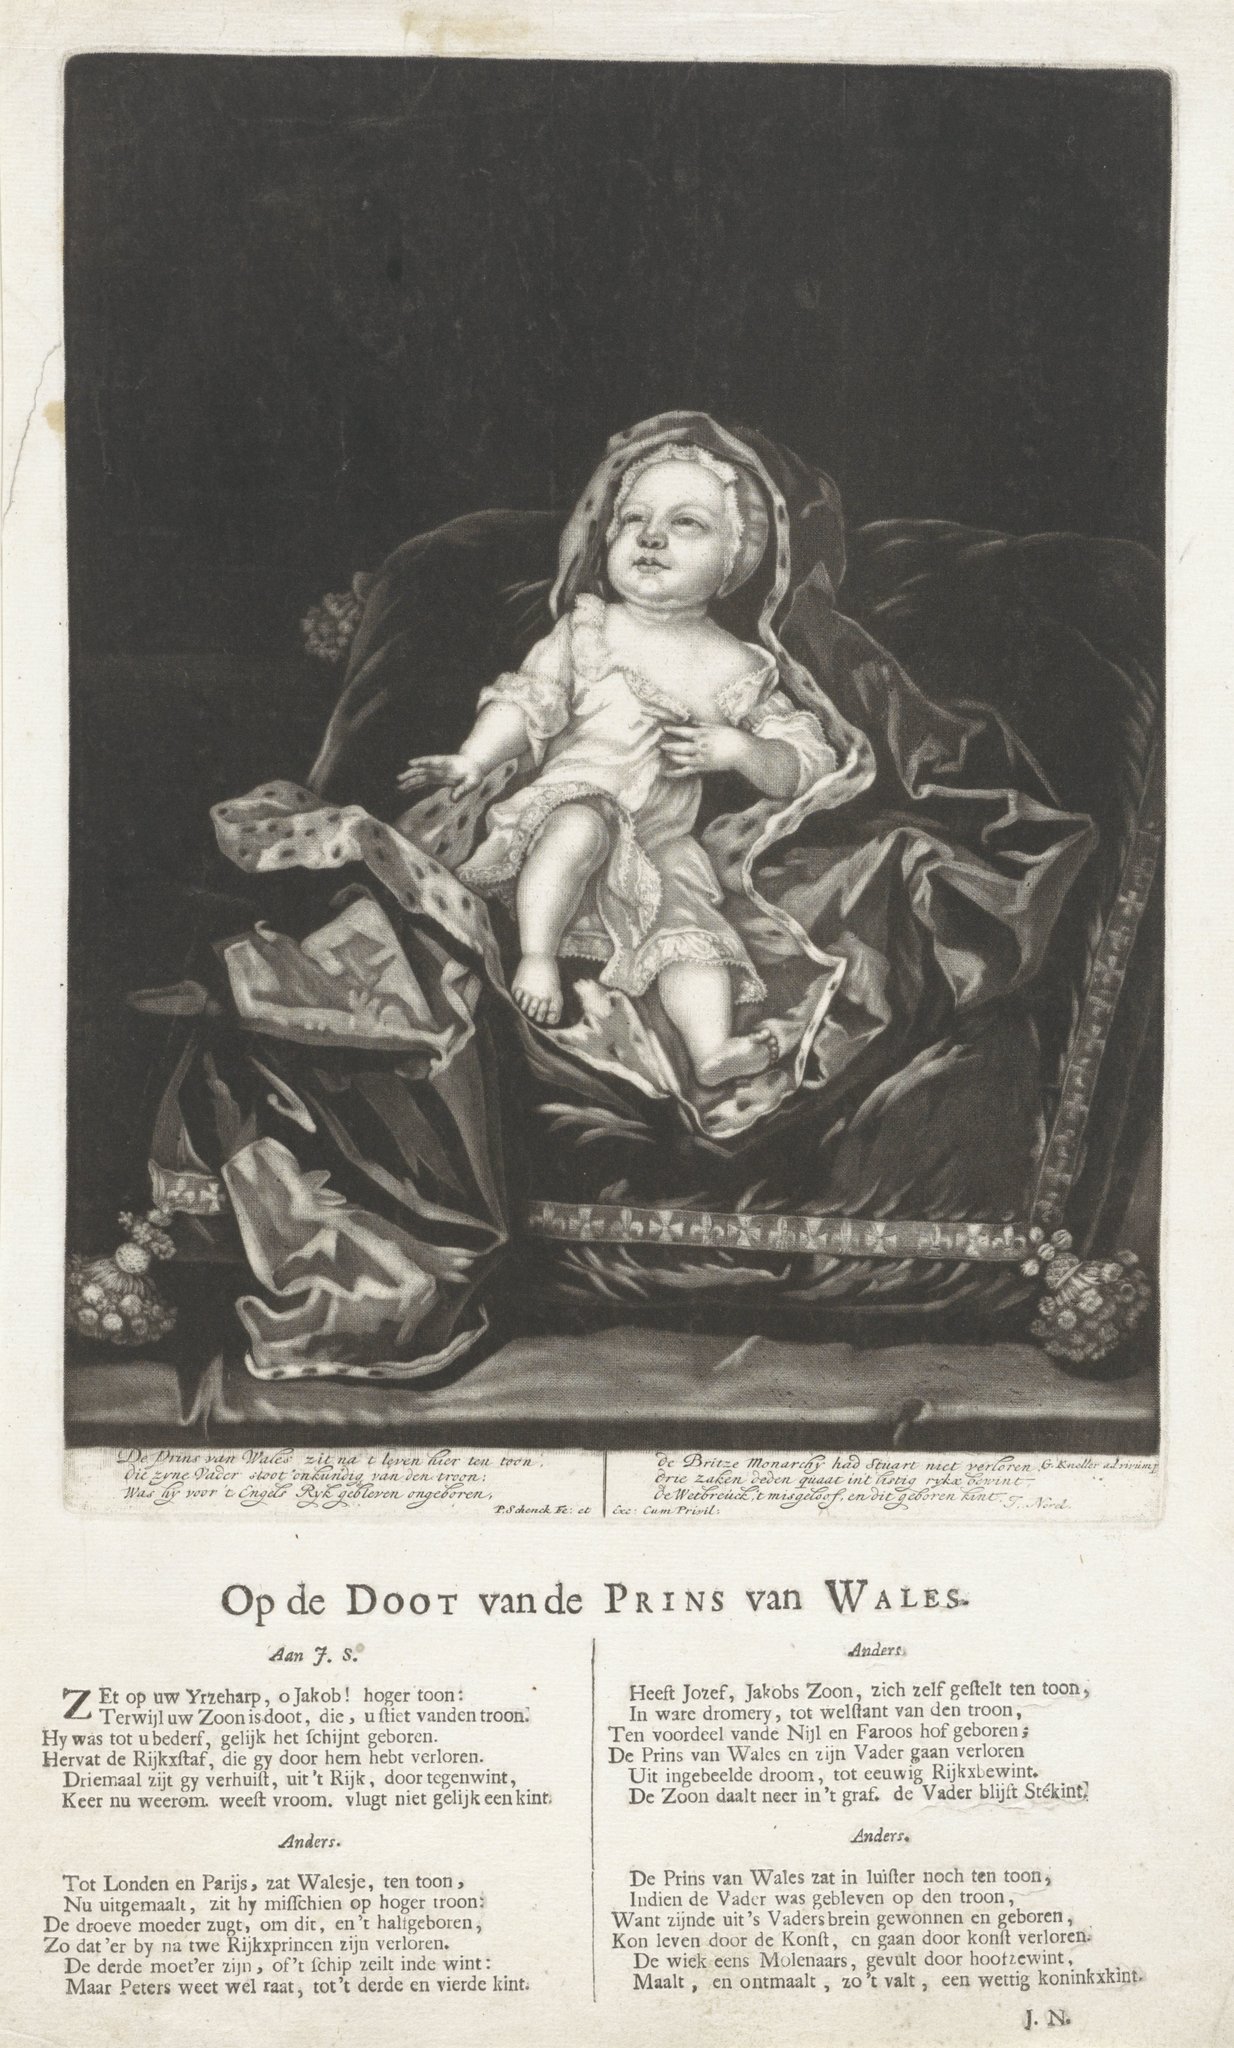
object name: print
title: Jacobus Frans Eduard, prins van Wales, 1688-1689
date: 1688-1713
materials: paper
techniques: engraving, letterpress printing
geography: amsterdam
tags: rome, infant, baby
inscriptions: collector's mark: Lugt 2228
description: Het kind Jacobus Frans Eduard, prins van Wales, zittend op een fluwelen kussen. In het onderschrift wordt hij genoemd als één van de drie problemen van Groot-Brittannië.